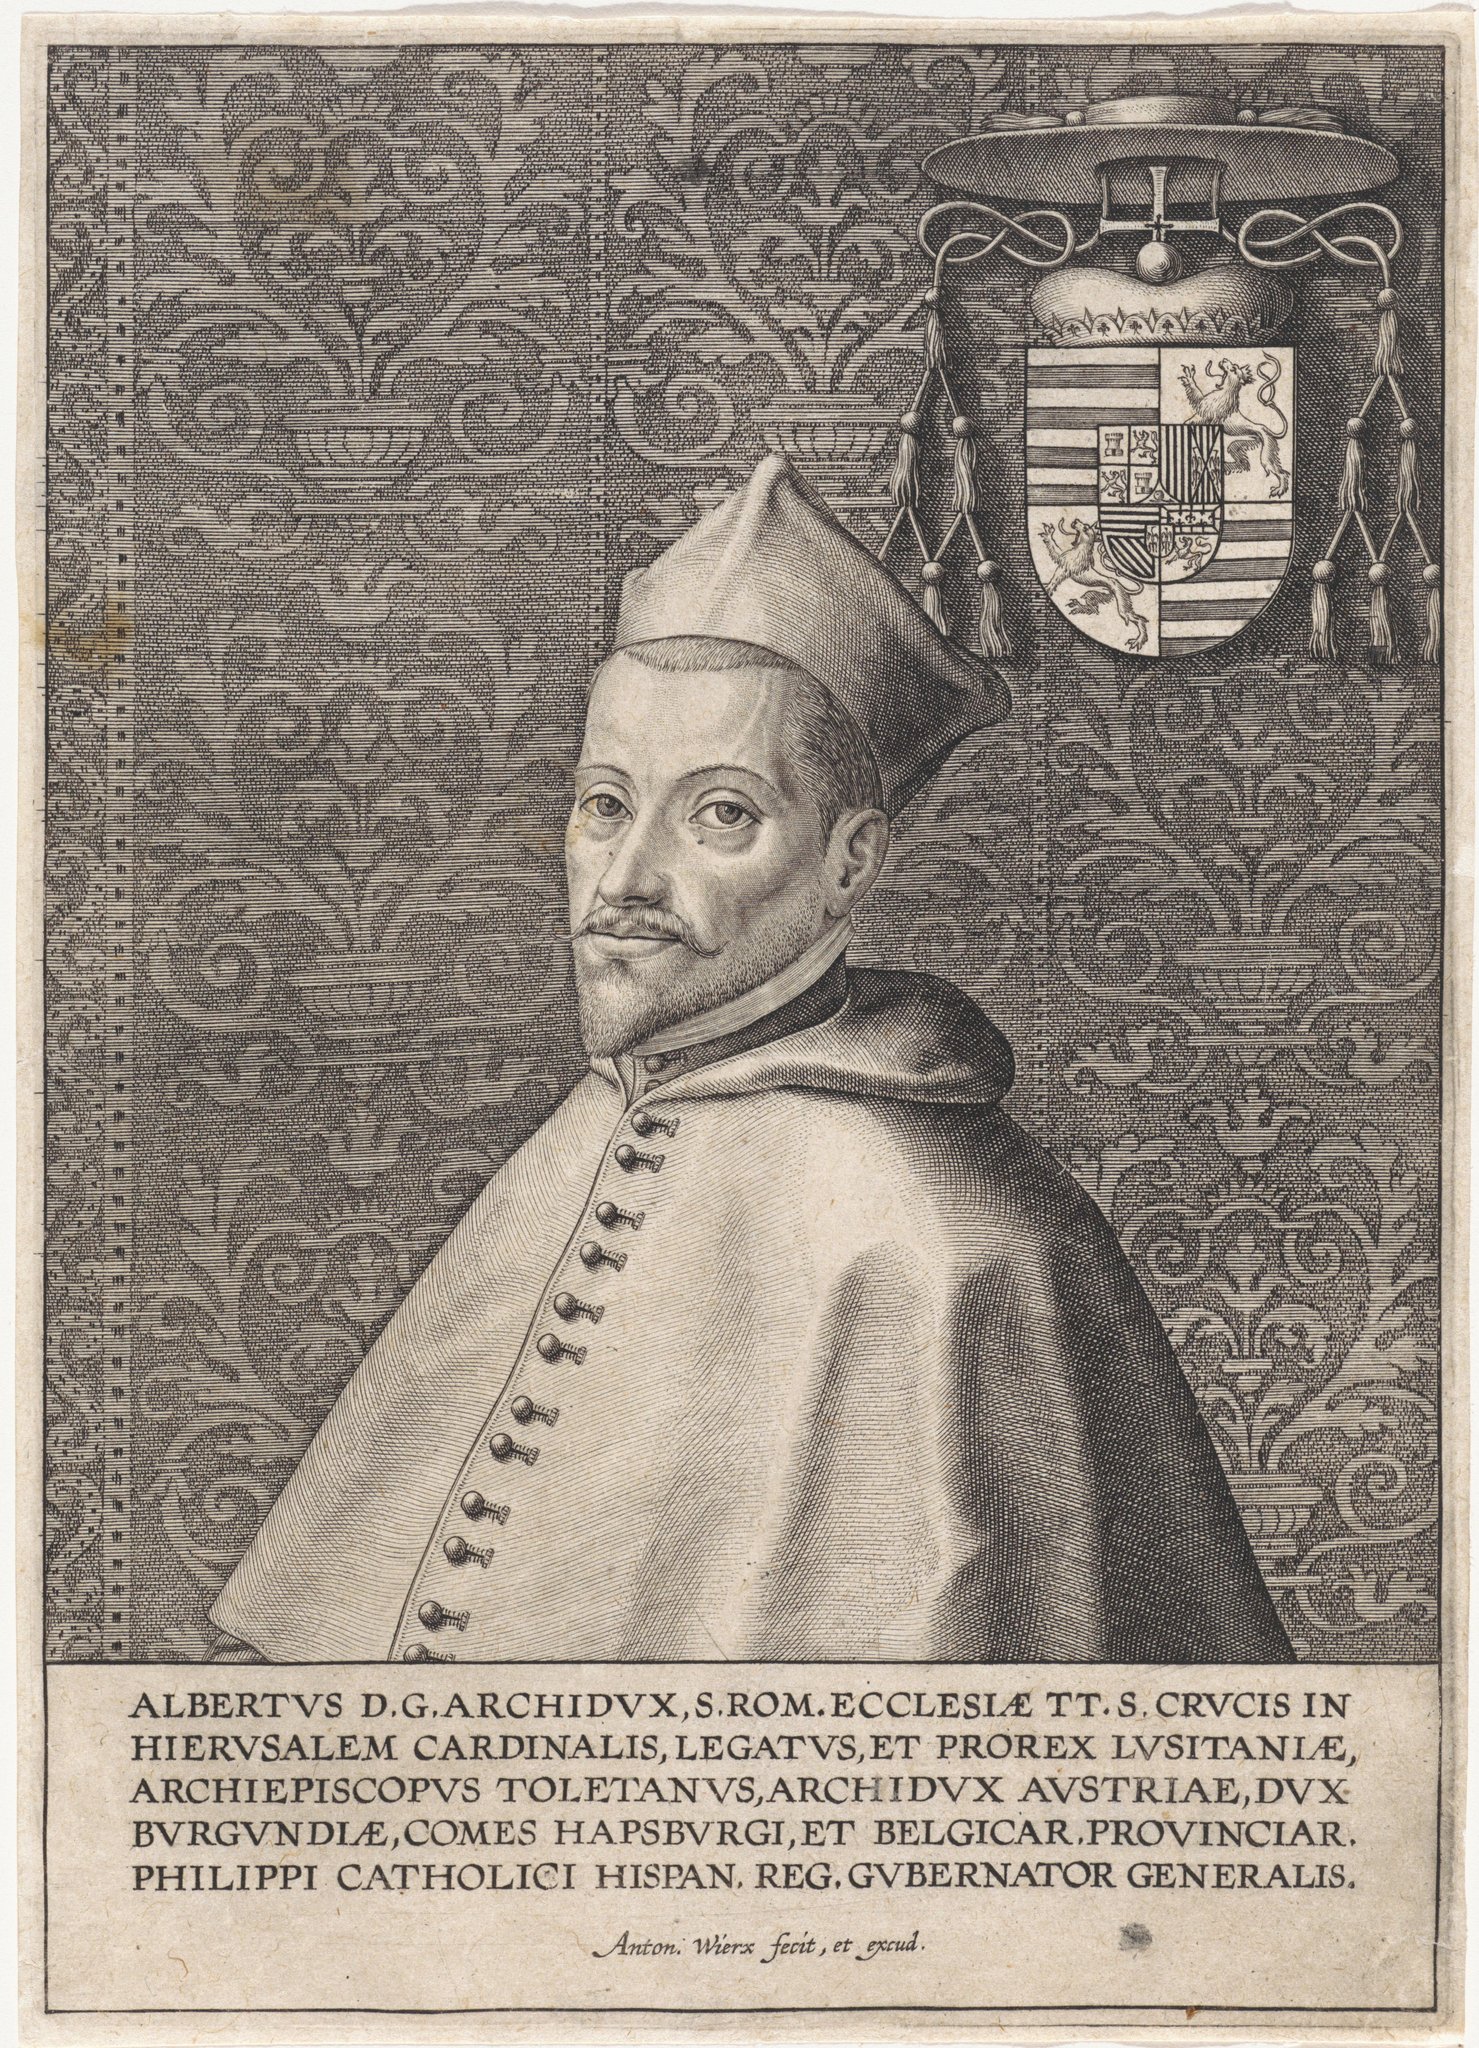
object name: print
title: Portret van Albrecht, aartshertog van Oostenrijk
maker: antonie wierix (ii)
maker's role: draughtsman, print maker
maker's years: 1555-1604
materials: paper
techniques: engraving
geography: antwerp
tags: brussels, albrecht aartshertog van oostenrijk, head-gear, armorial bearing, heraldry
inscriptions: collector's mark: Lugt 2228, number: ‘22. - 49.’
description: Busteportret van Albrecht, aartshertog van Oostenrijk. Hij draagt een biretta. Rechtsboven zijn wapenschild. In de marge een vijfregelig onderschrift in het Latijn.